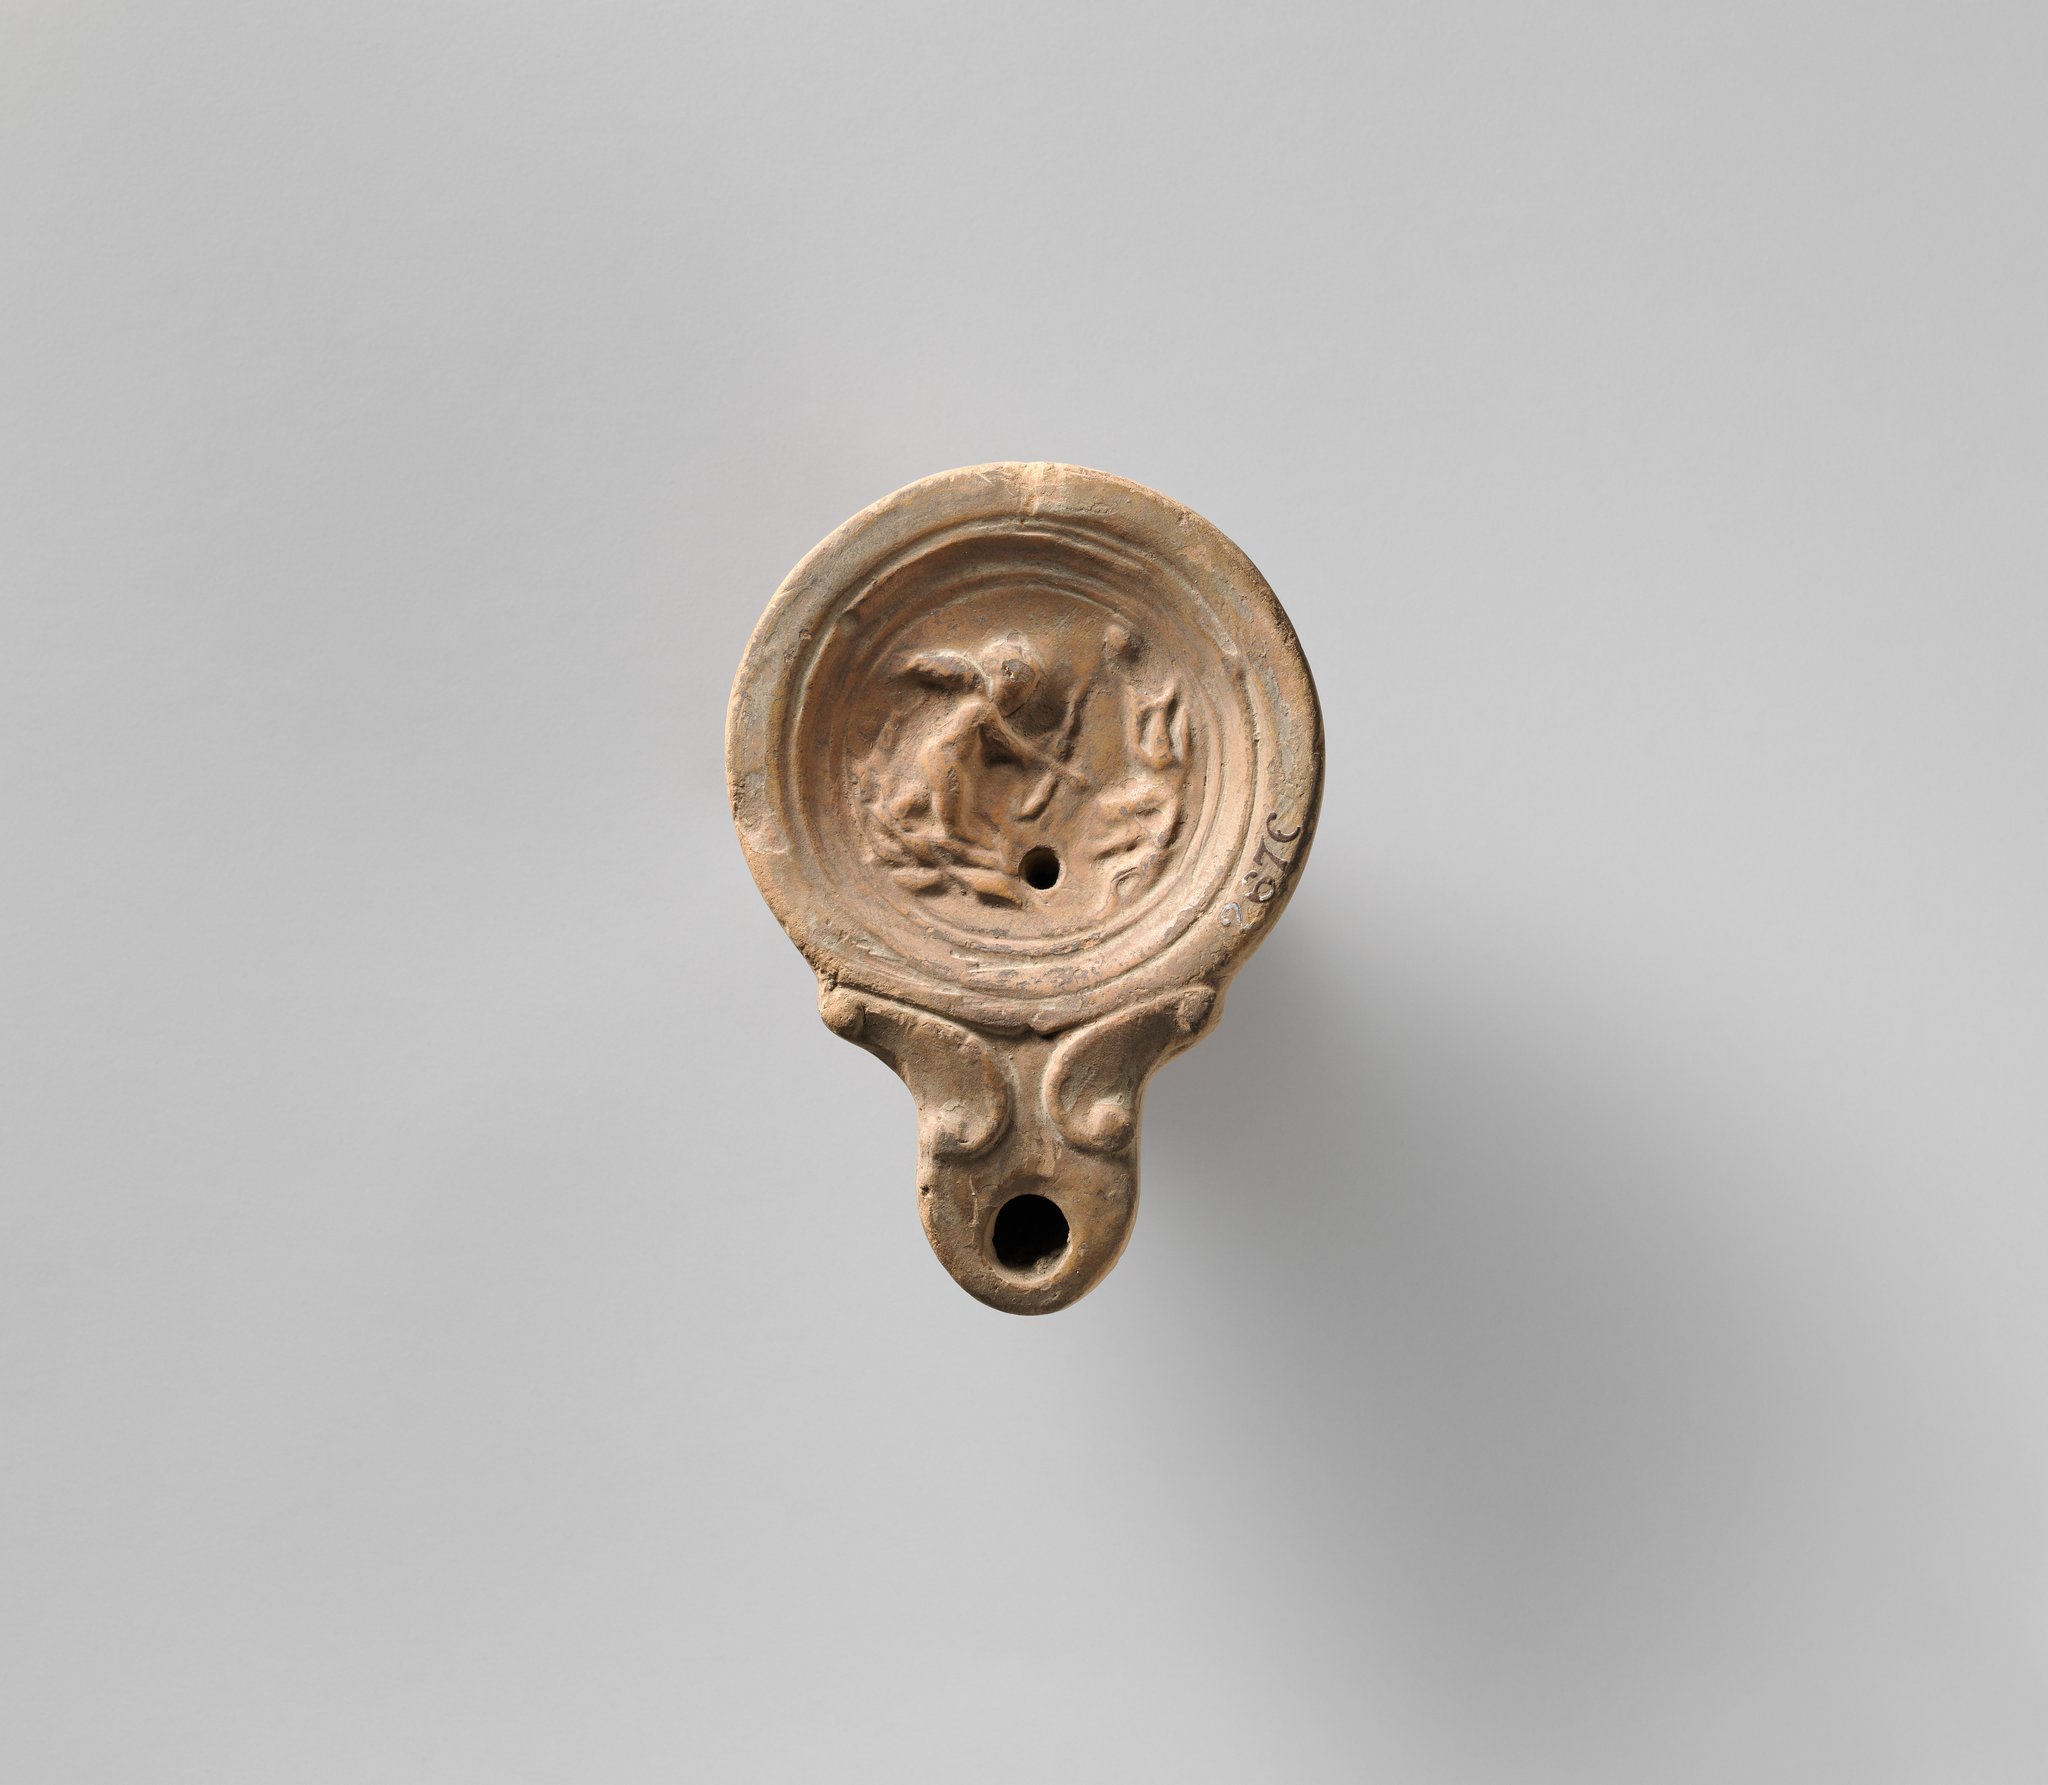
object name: lamp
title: Terracotta oil lamp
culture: roman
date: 40-100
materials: terracotta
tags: eros